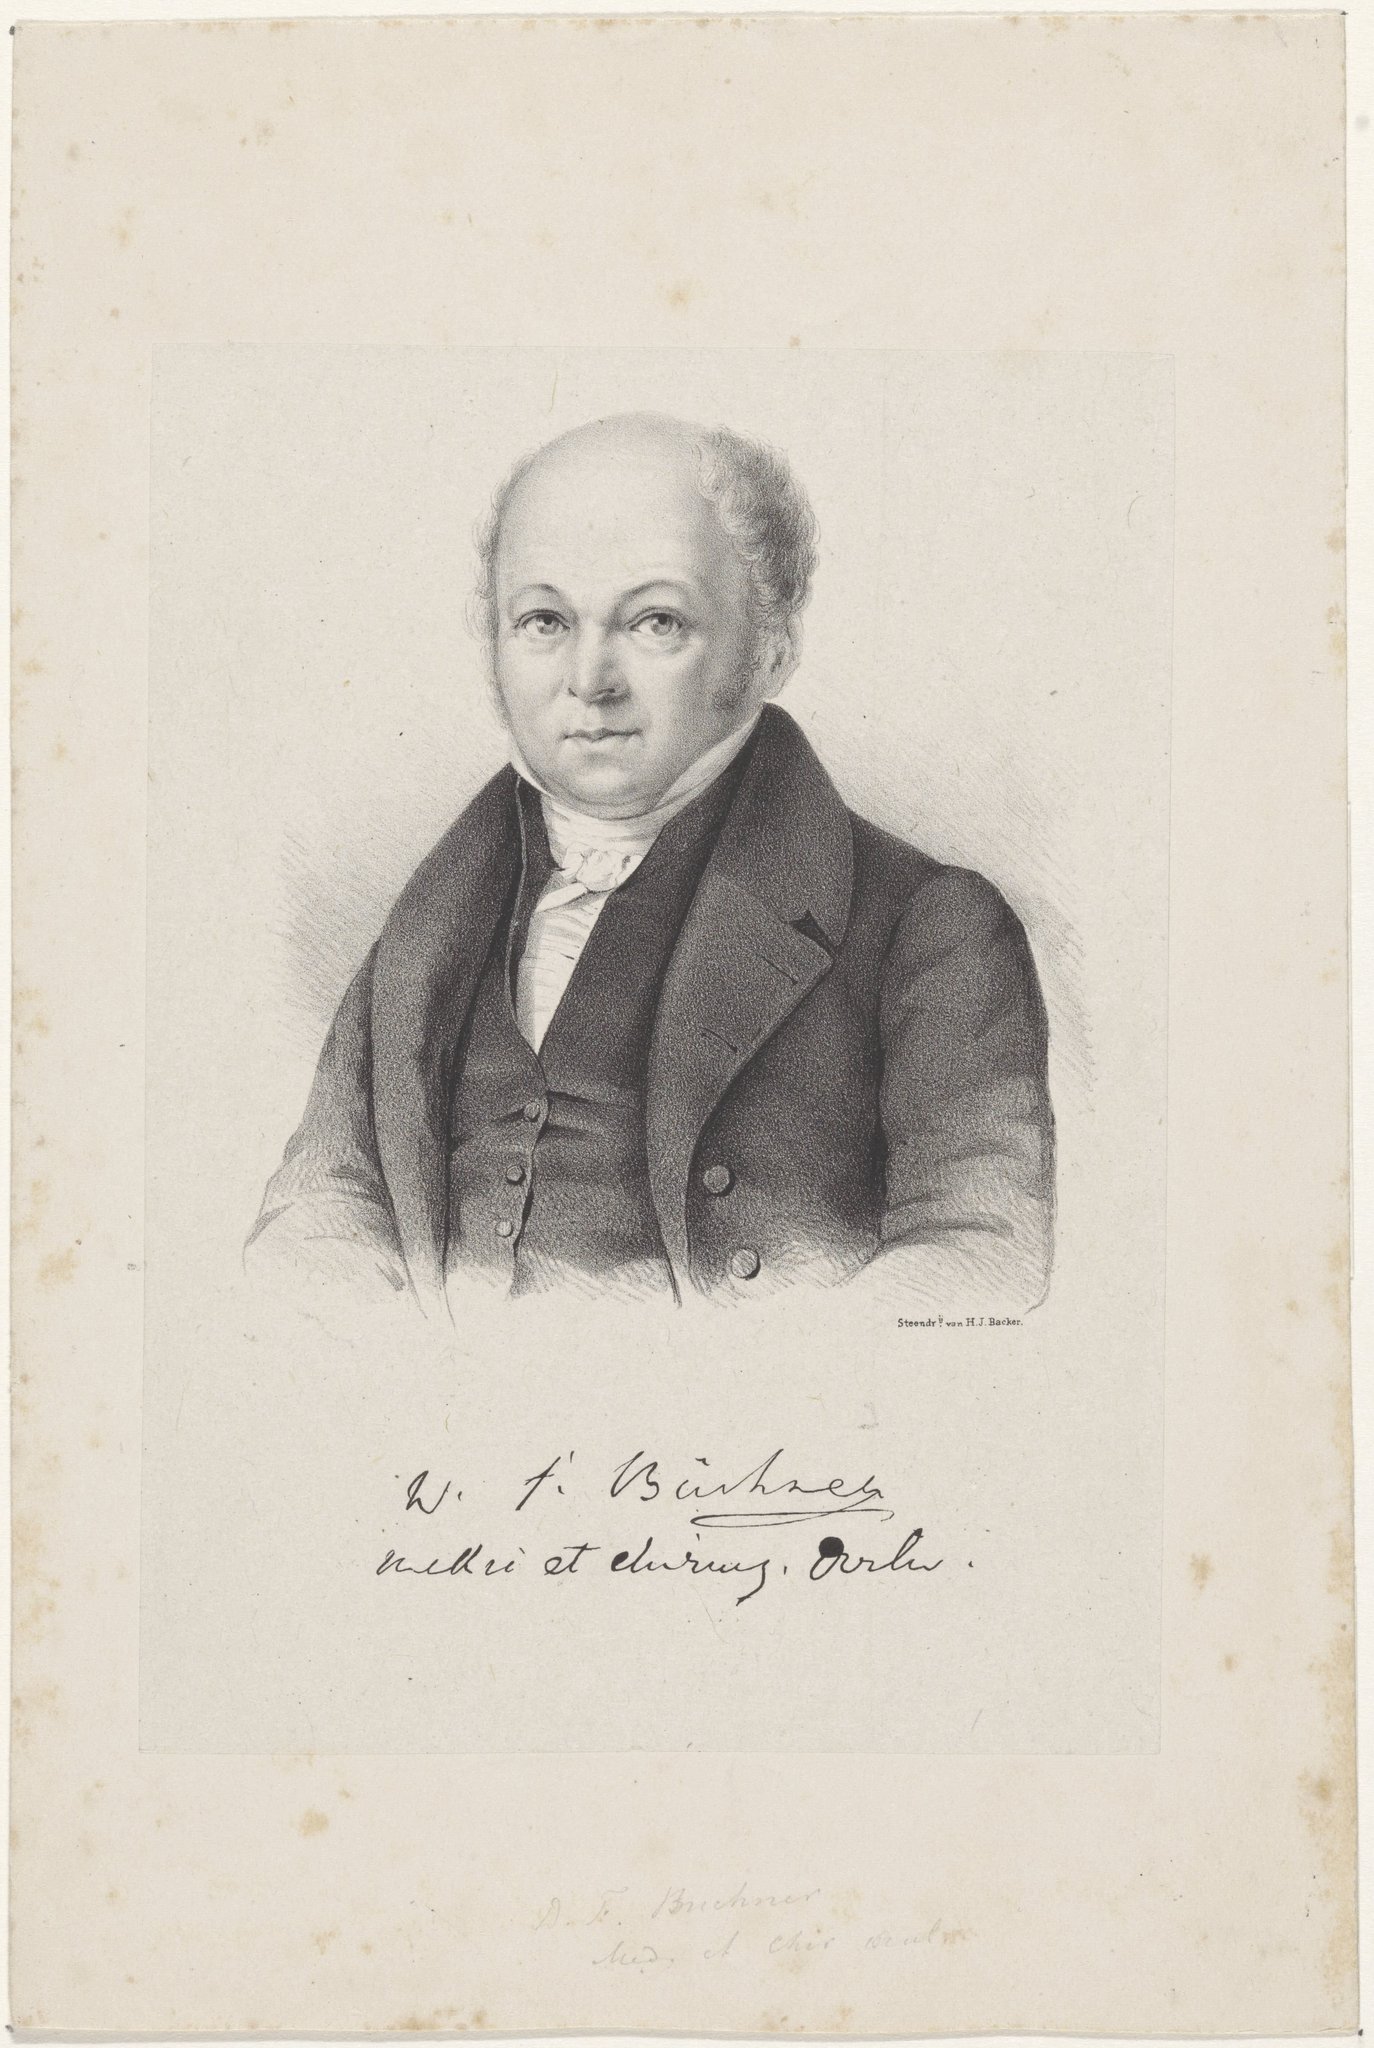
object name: print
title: Portret van Willem Frederik Büchner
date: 1822-1845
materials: paper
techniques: lithograph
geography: dordrecht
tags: gouda, historical persons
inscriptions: inscription: ‘W.F. Büchner / Med(...) et chirurg (...)’, collector's mark: Lugt 2228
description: Onder het portret de naam en het beroep van de geportretteerde.